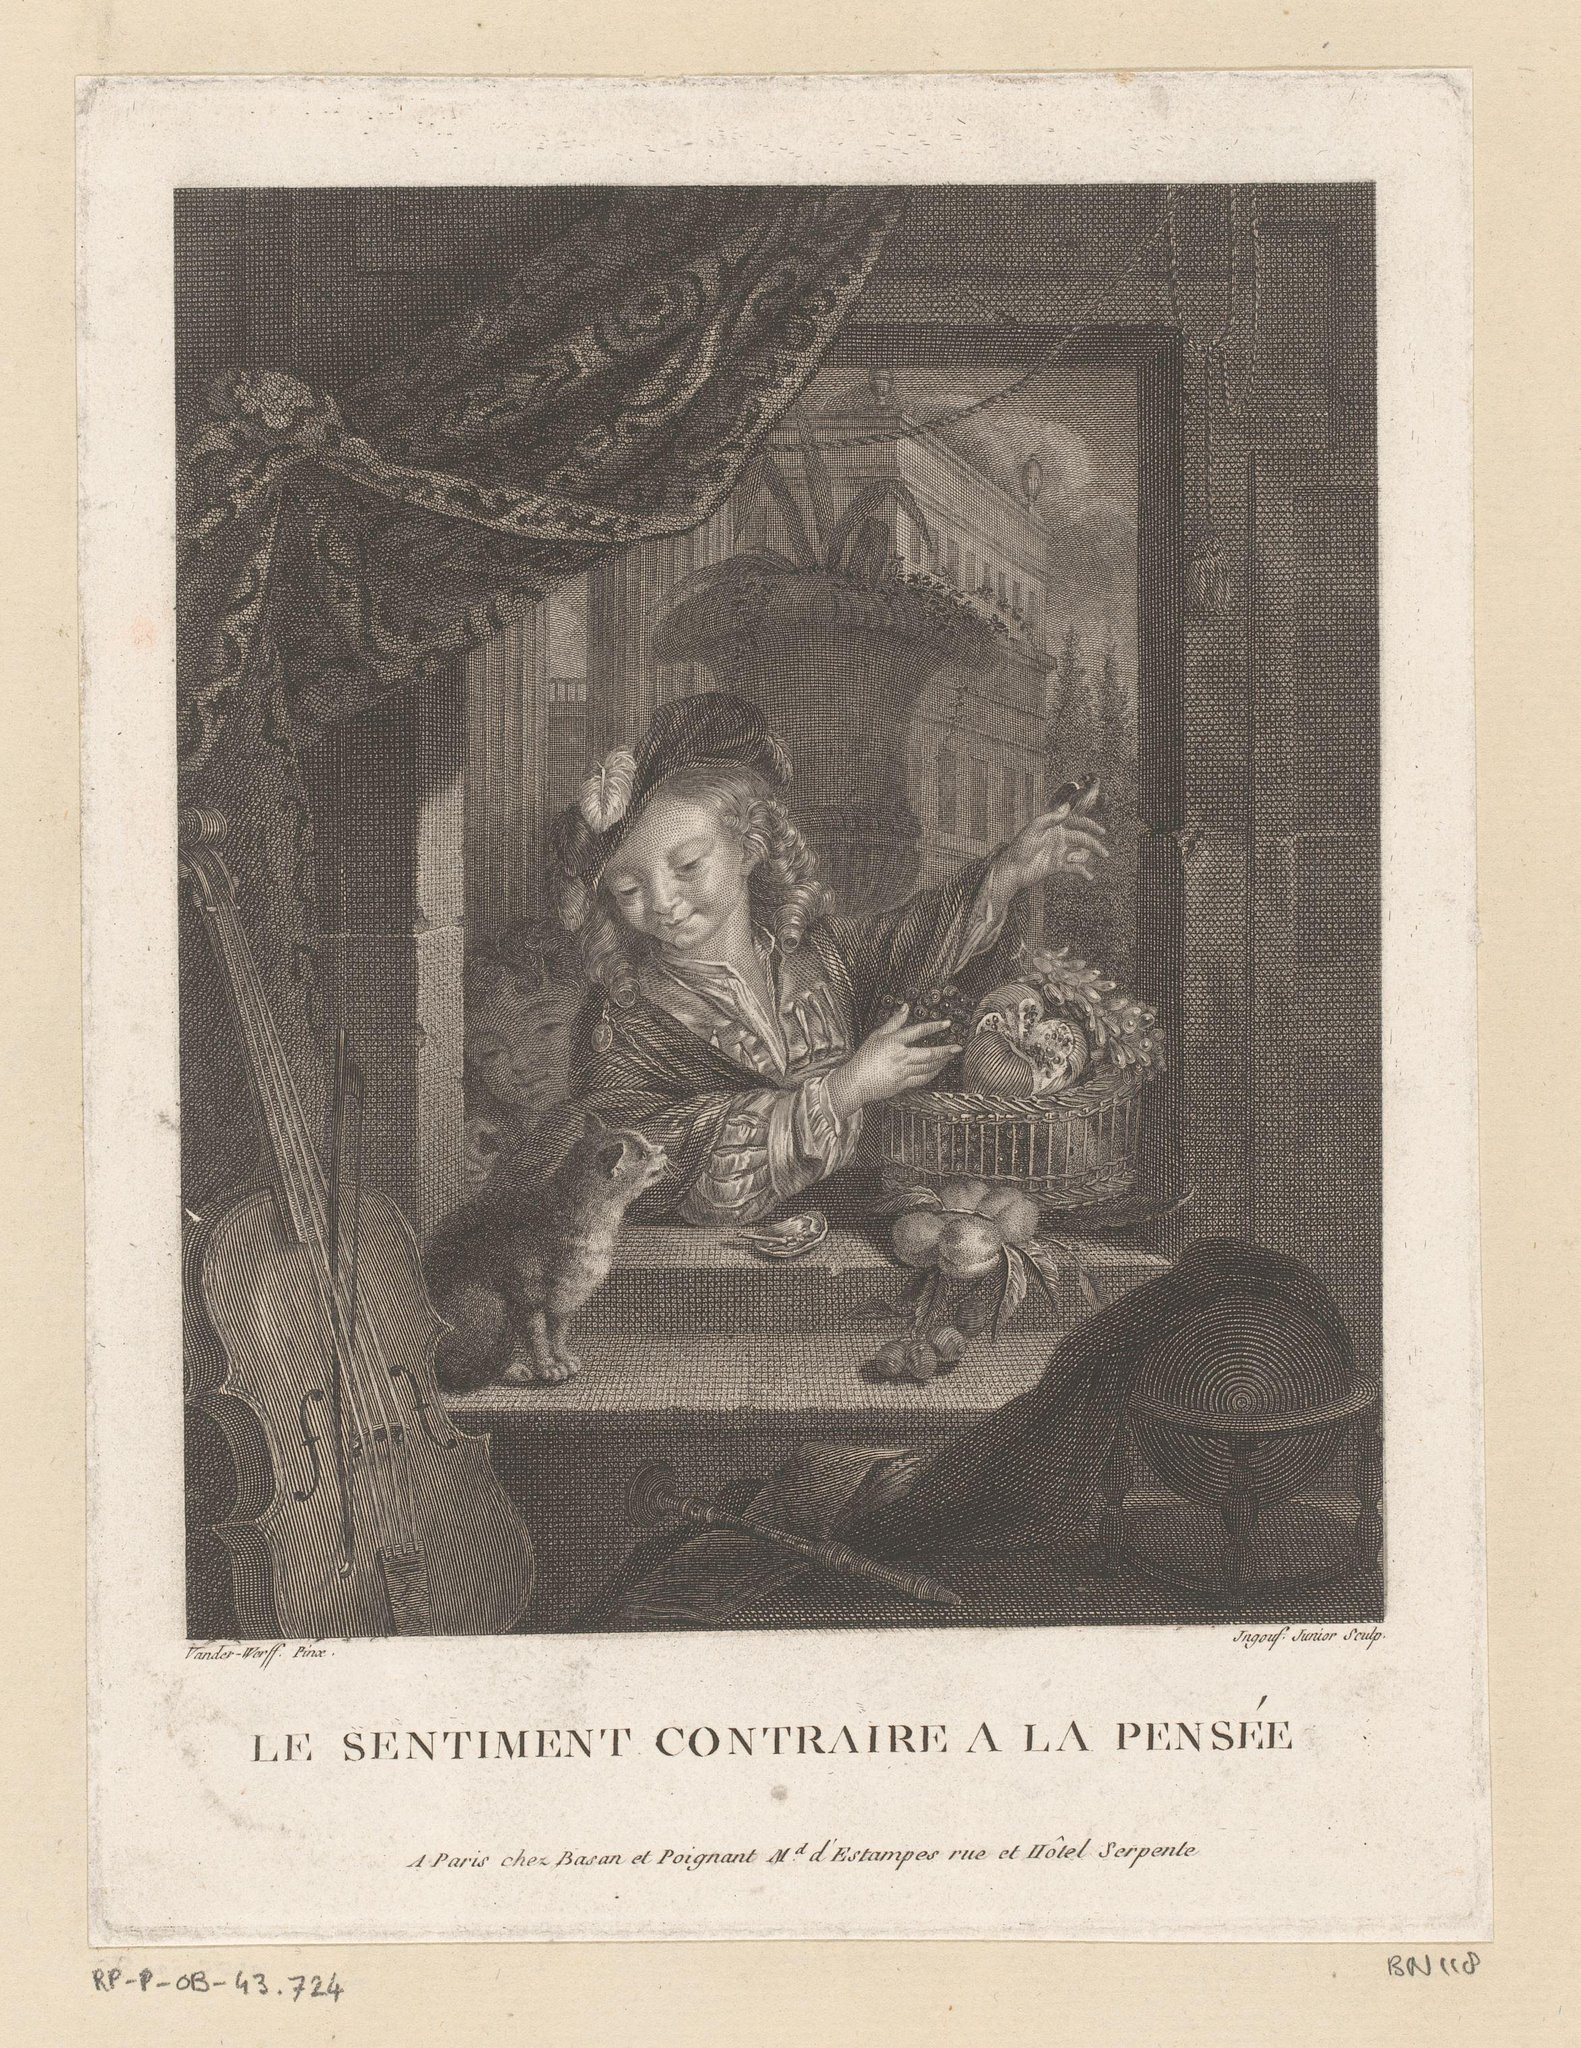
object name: print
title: Le Sentiment contraire à la Pensée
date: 1779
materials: paper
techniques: engraving, etching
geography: france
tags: cat, birds, open window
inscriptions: collector's mark: Lugt 240